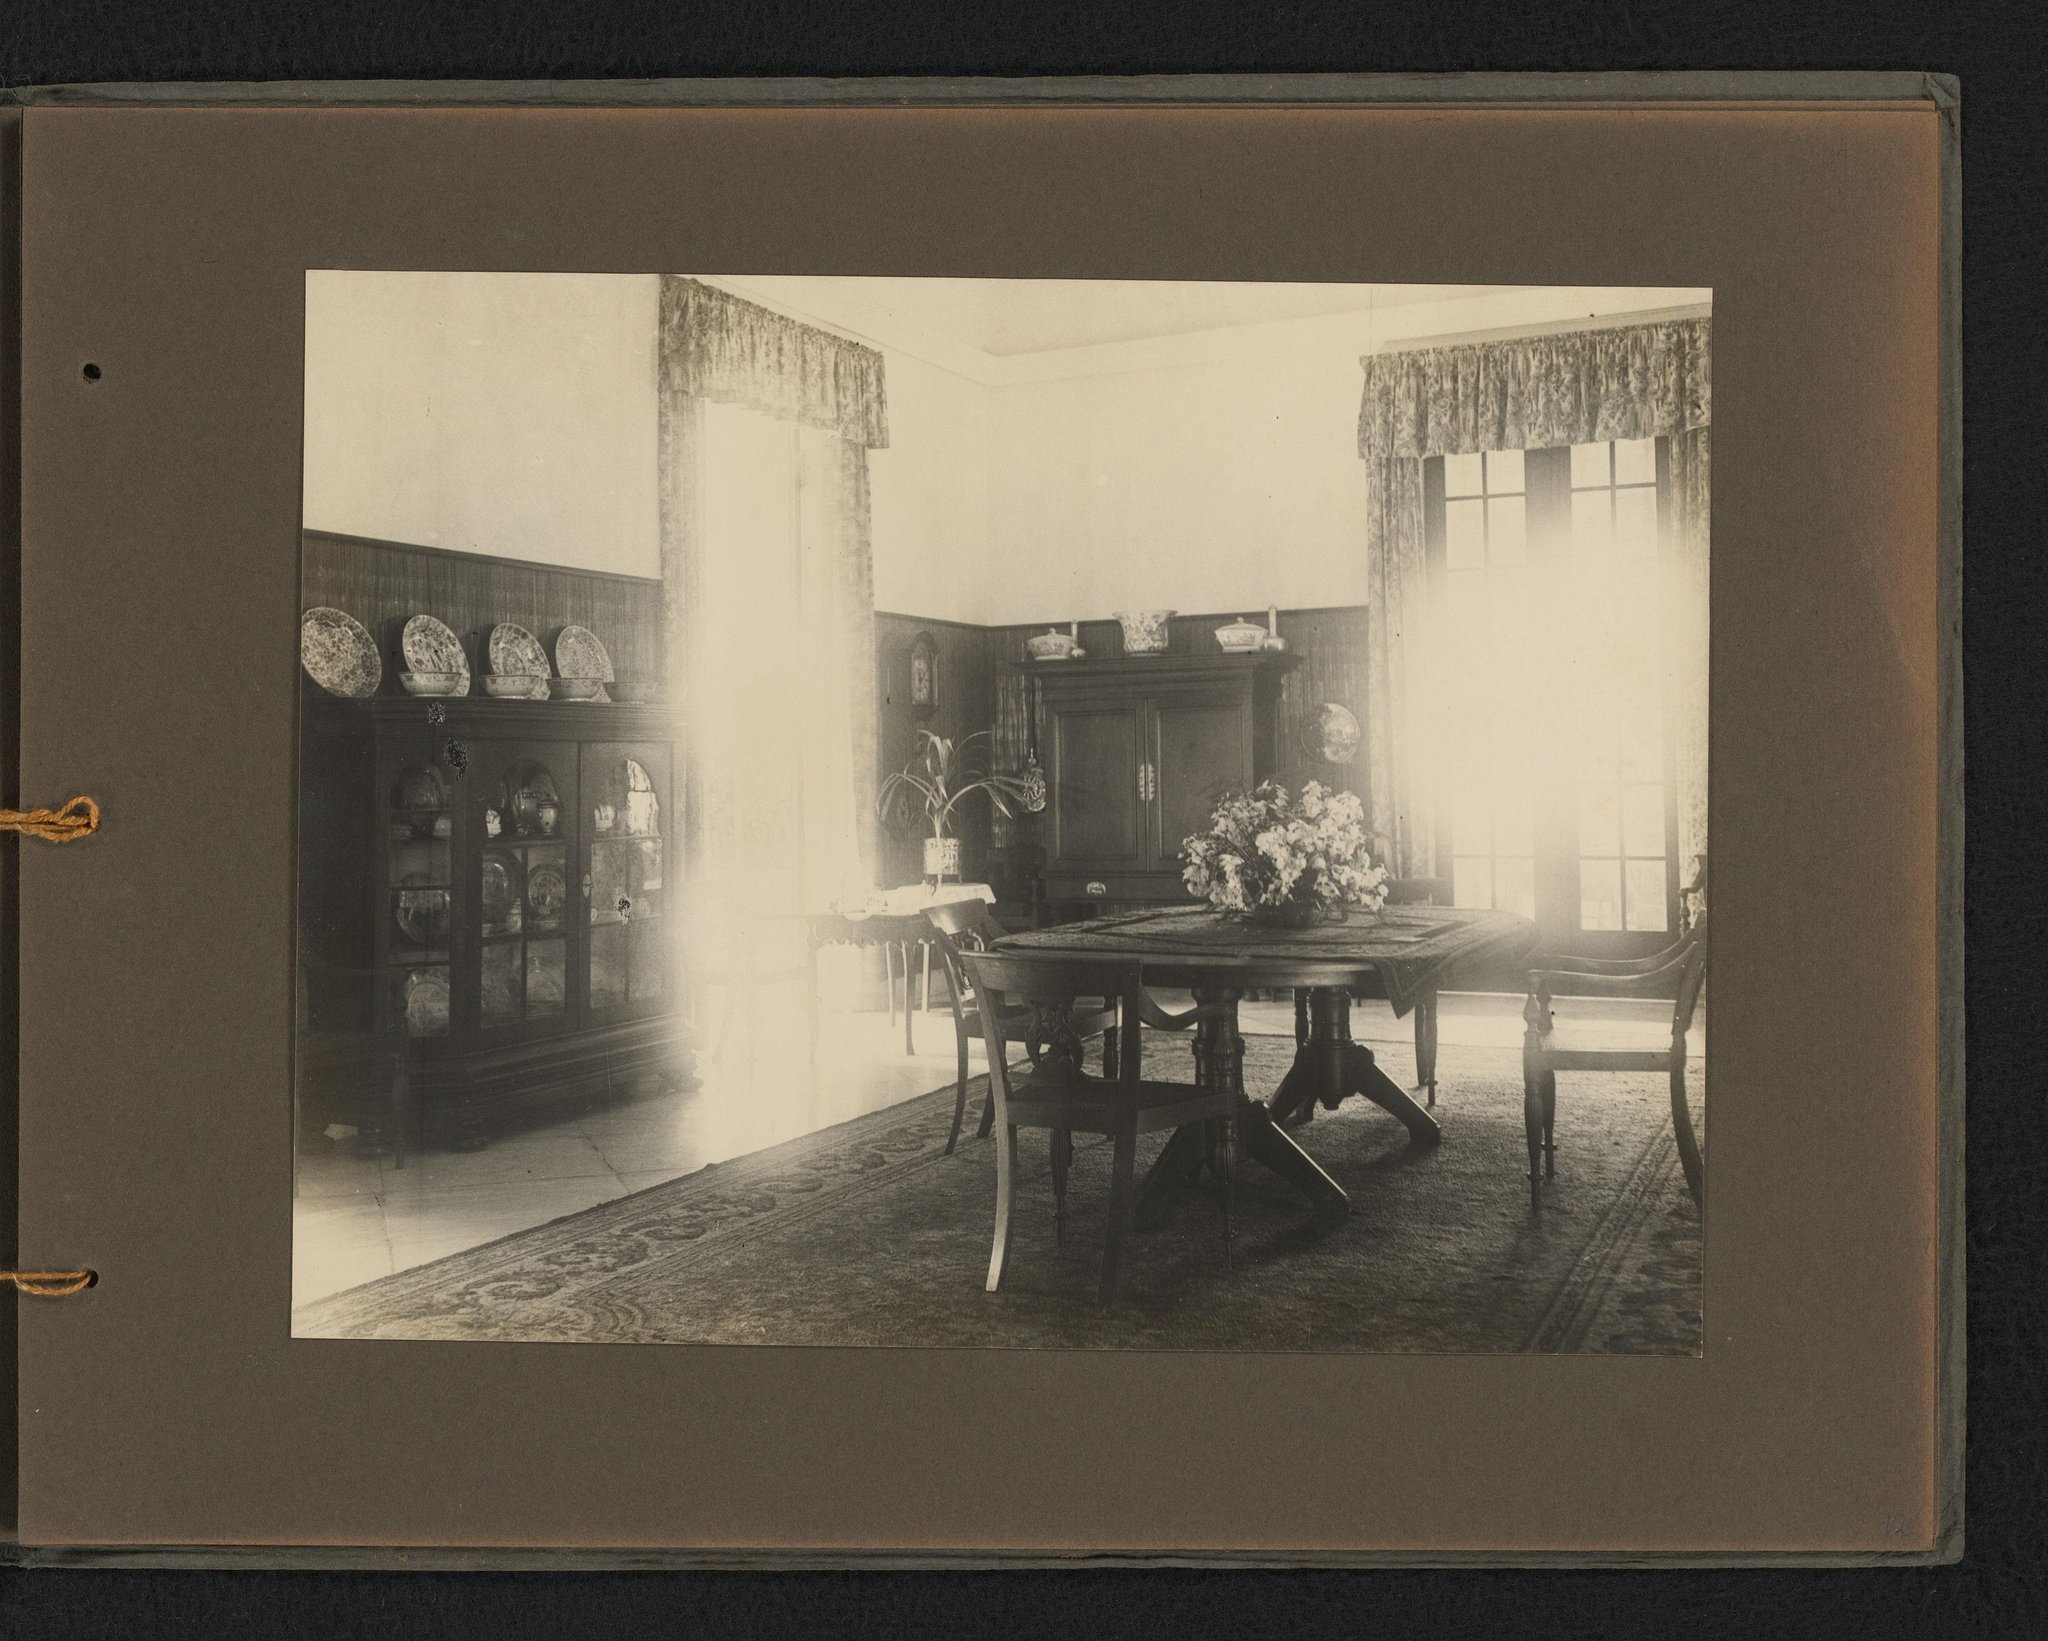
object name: album leaf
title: Interieur van de eetkamer in de ambtswoning van de Javasche Bank te Batavia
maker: Anonymous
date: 1921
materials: paper, cardboard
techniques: gelatin silver print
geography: batavia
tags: interior ~ representation of a building, dining-room, batavia